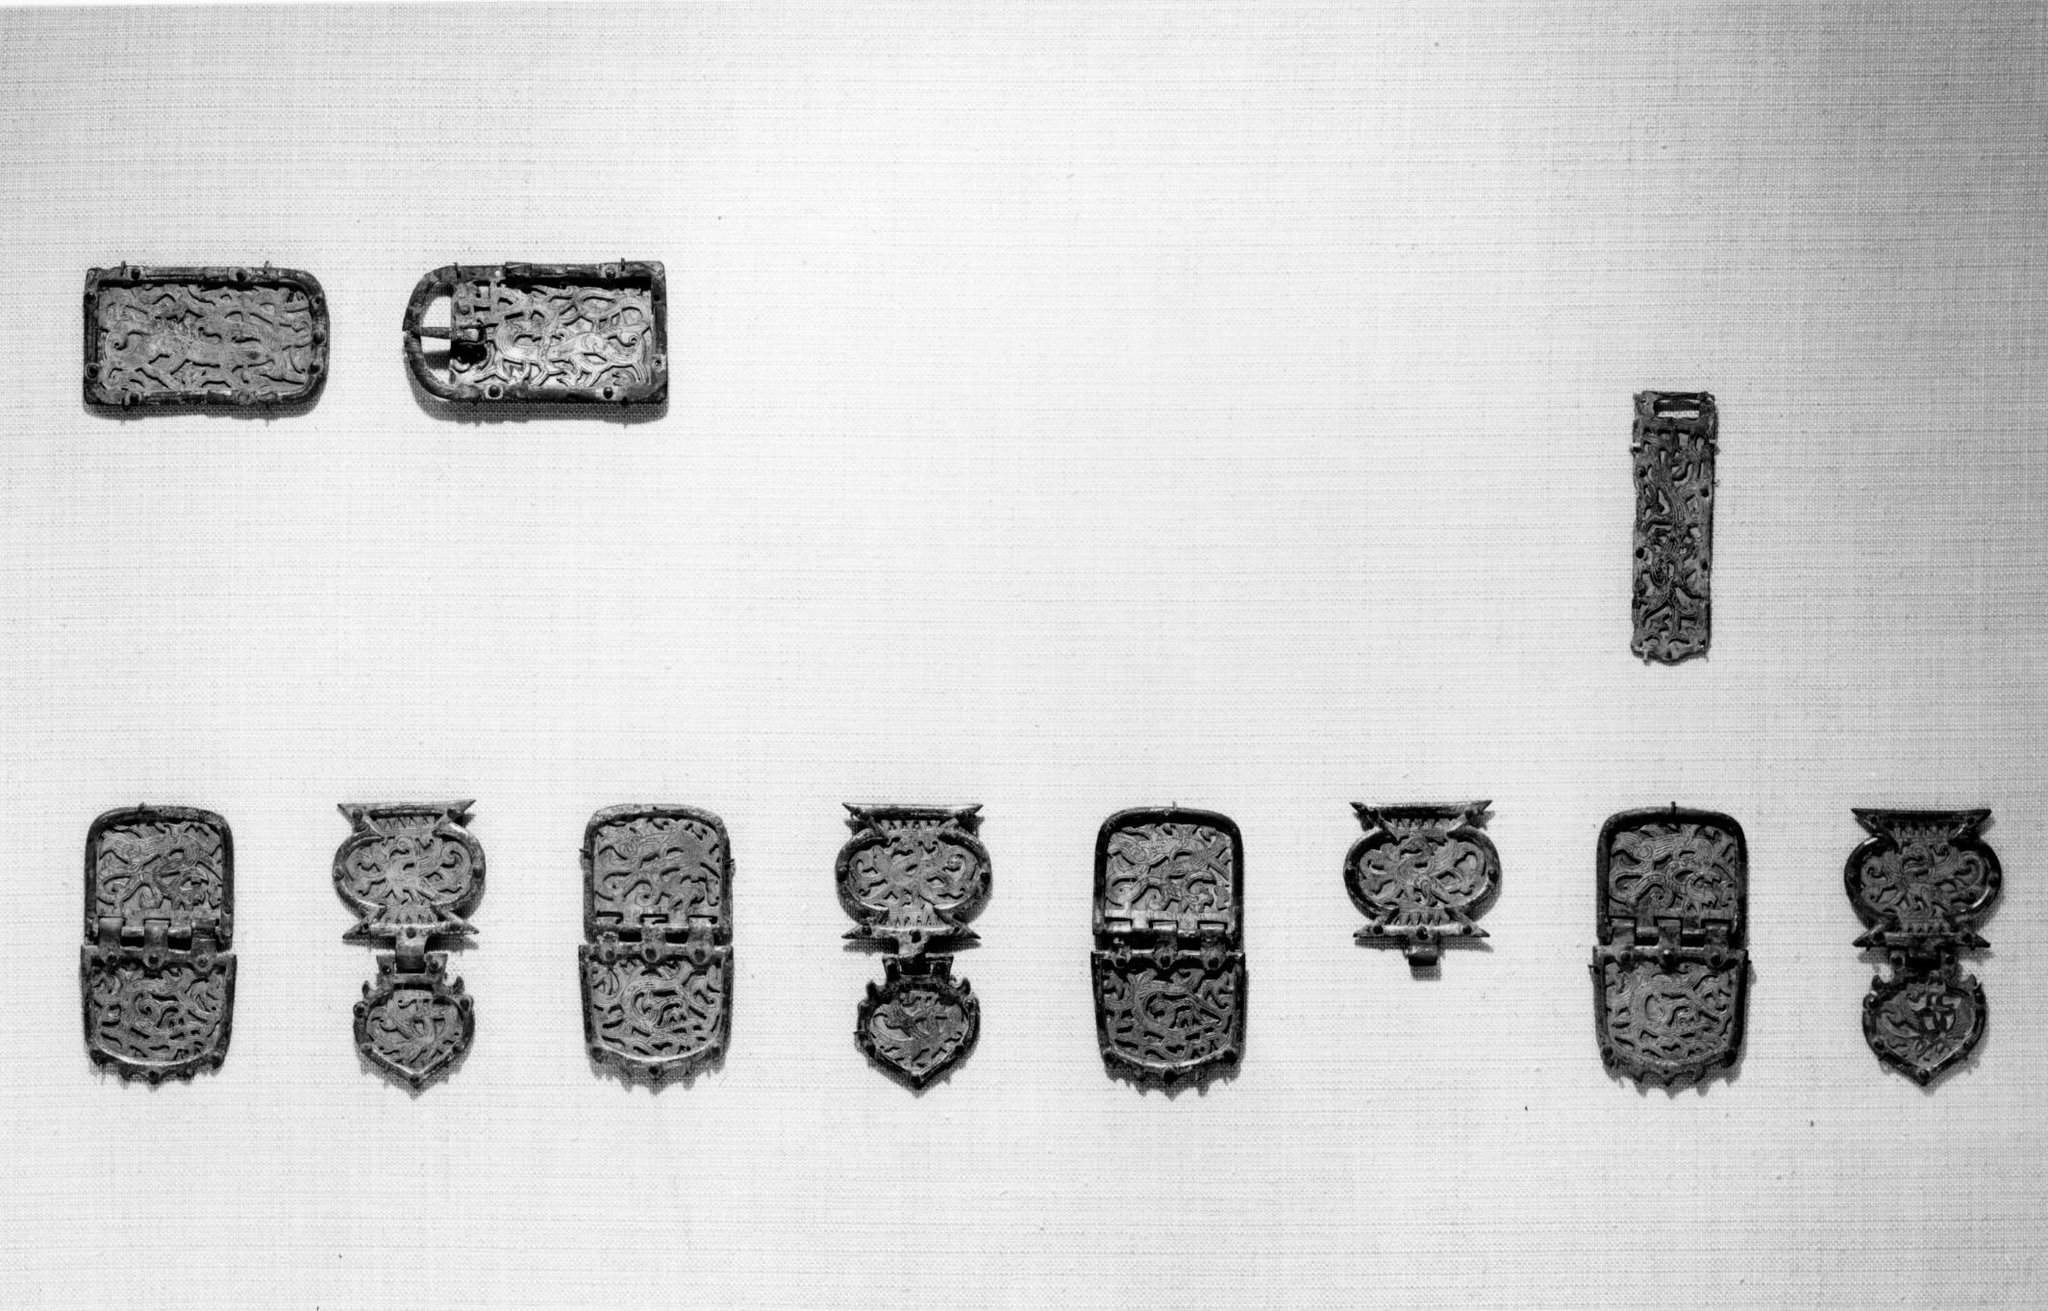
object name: belt plaque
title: Set of Ten Belt Plaques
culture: chinese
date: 267-333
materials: gilt bronze